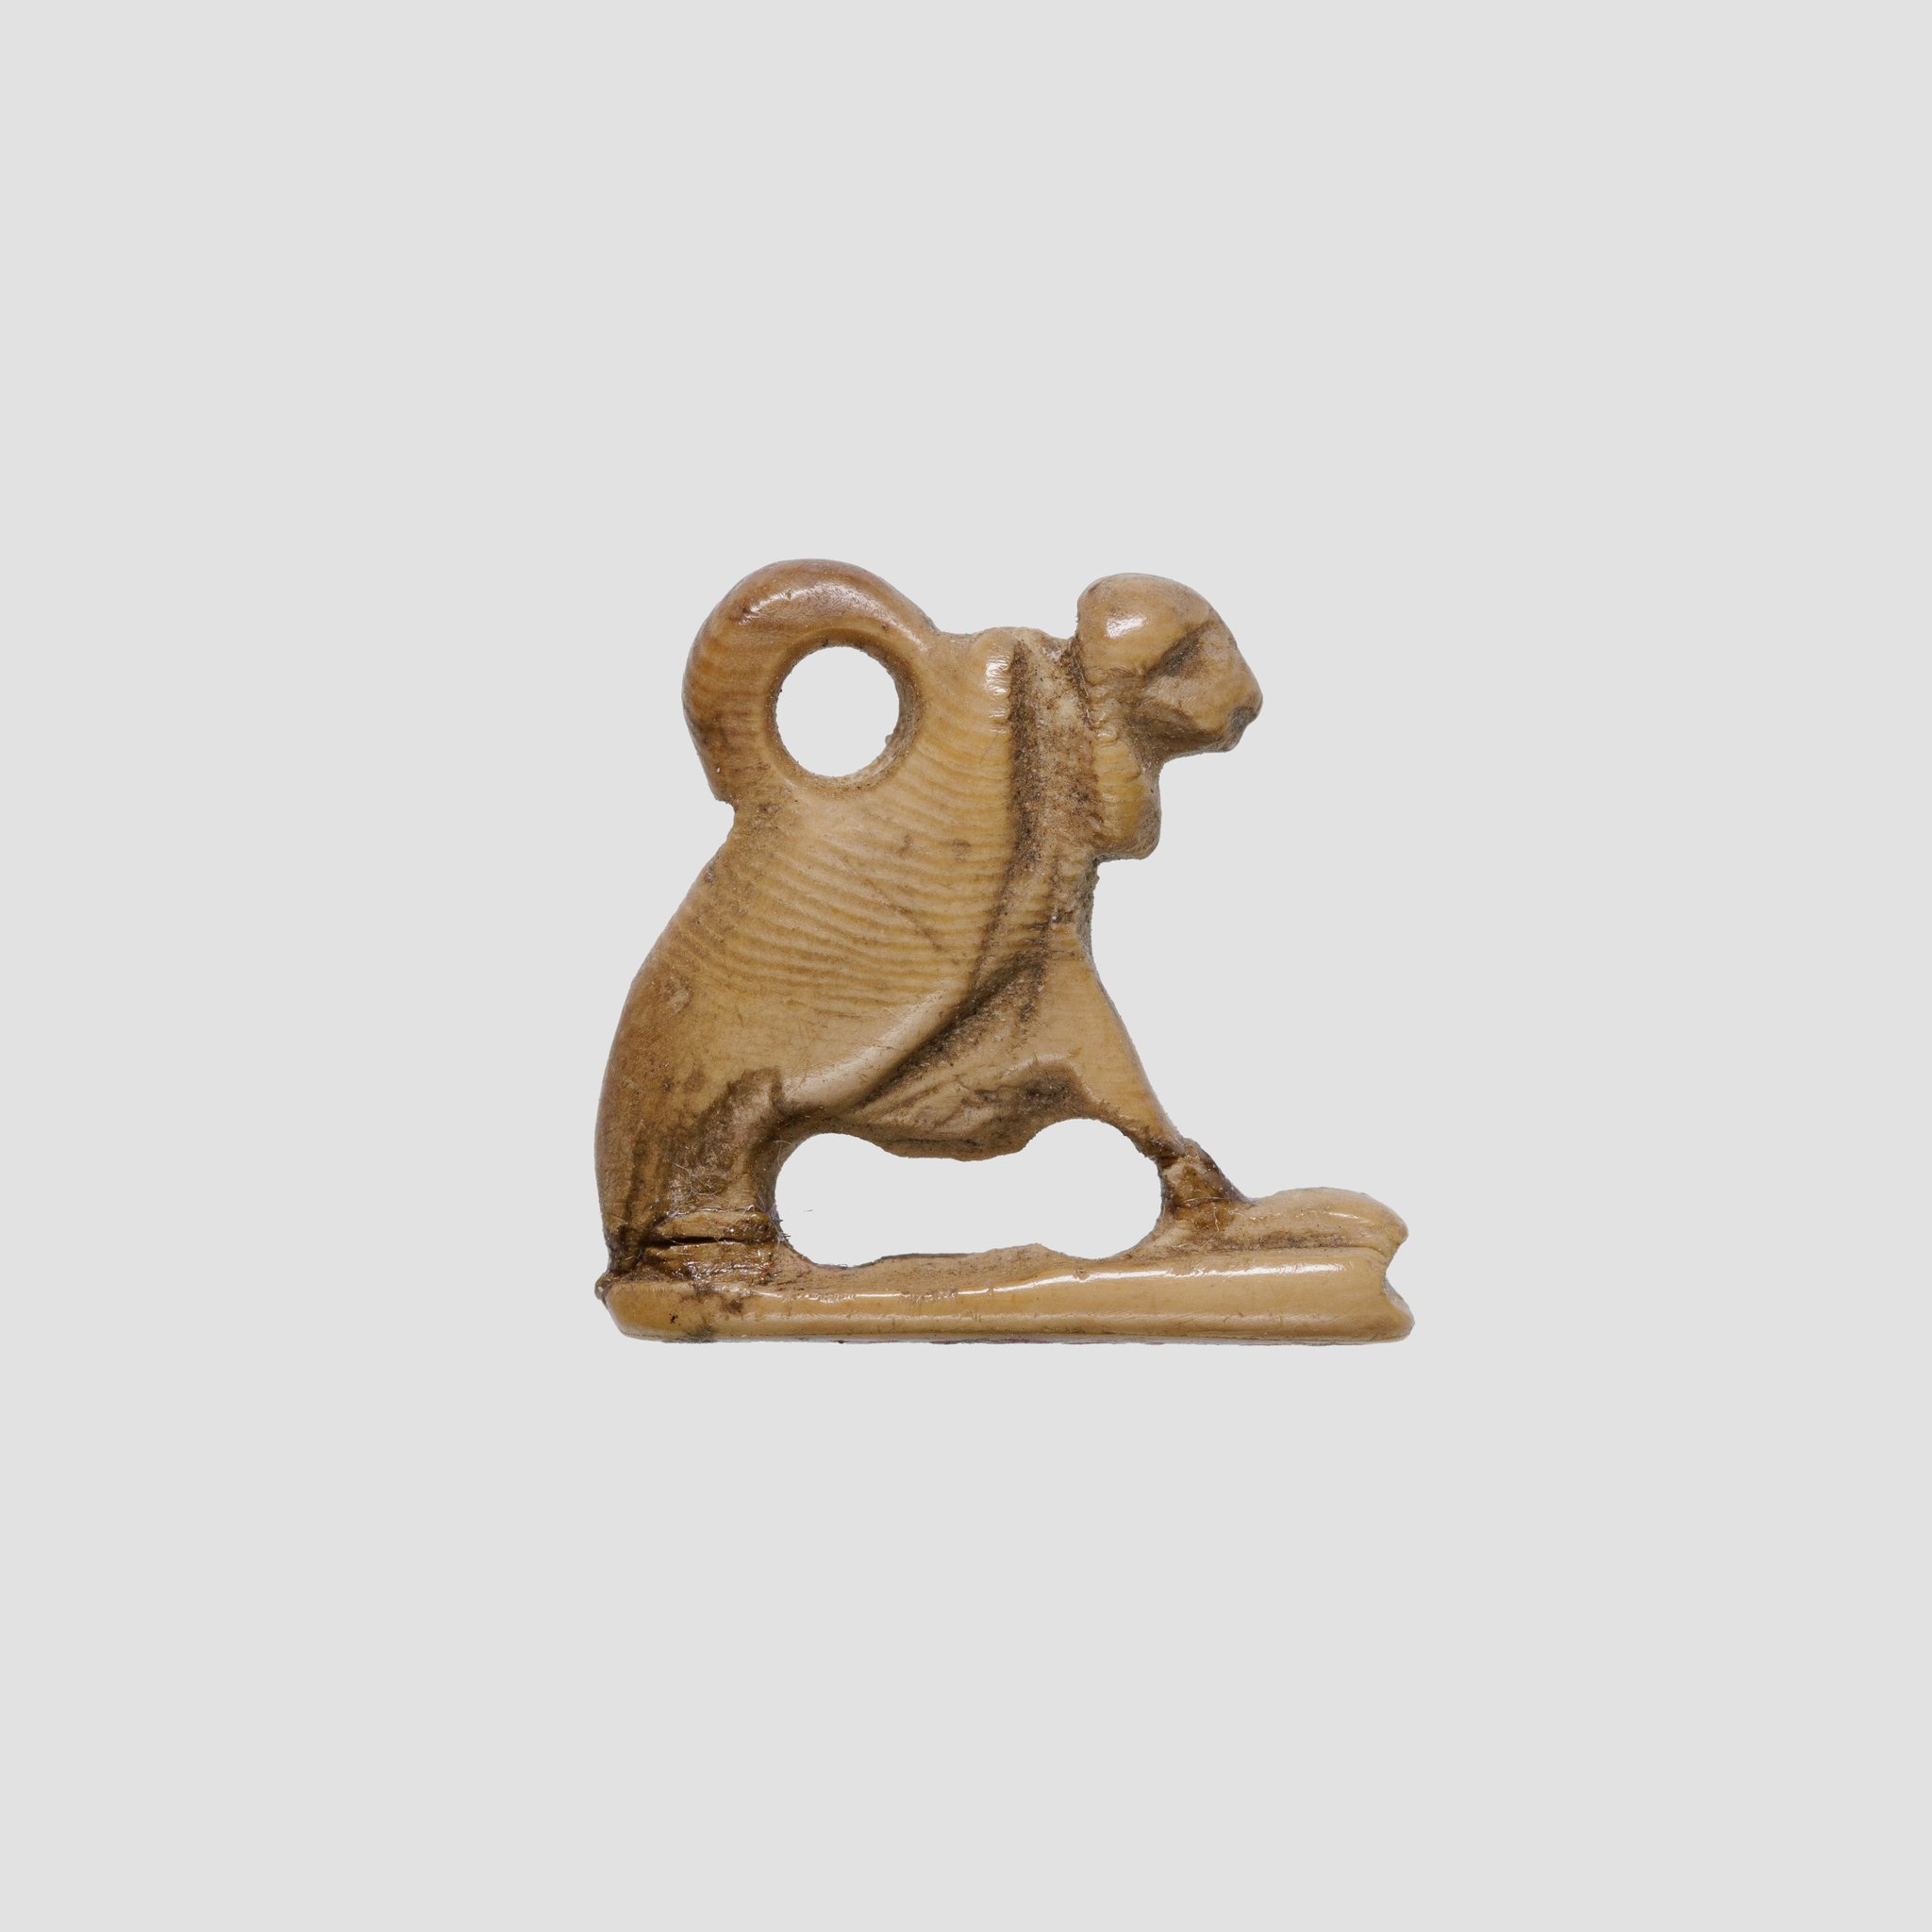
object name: amulet, vulture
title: Vulture amulet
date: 2150-1950 BCE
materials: bone, ivory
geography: egypt